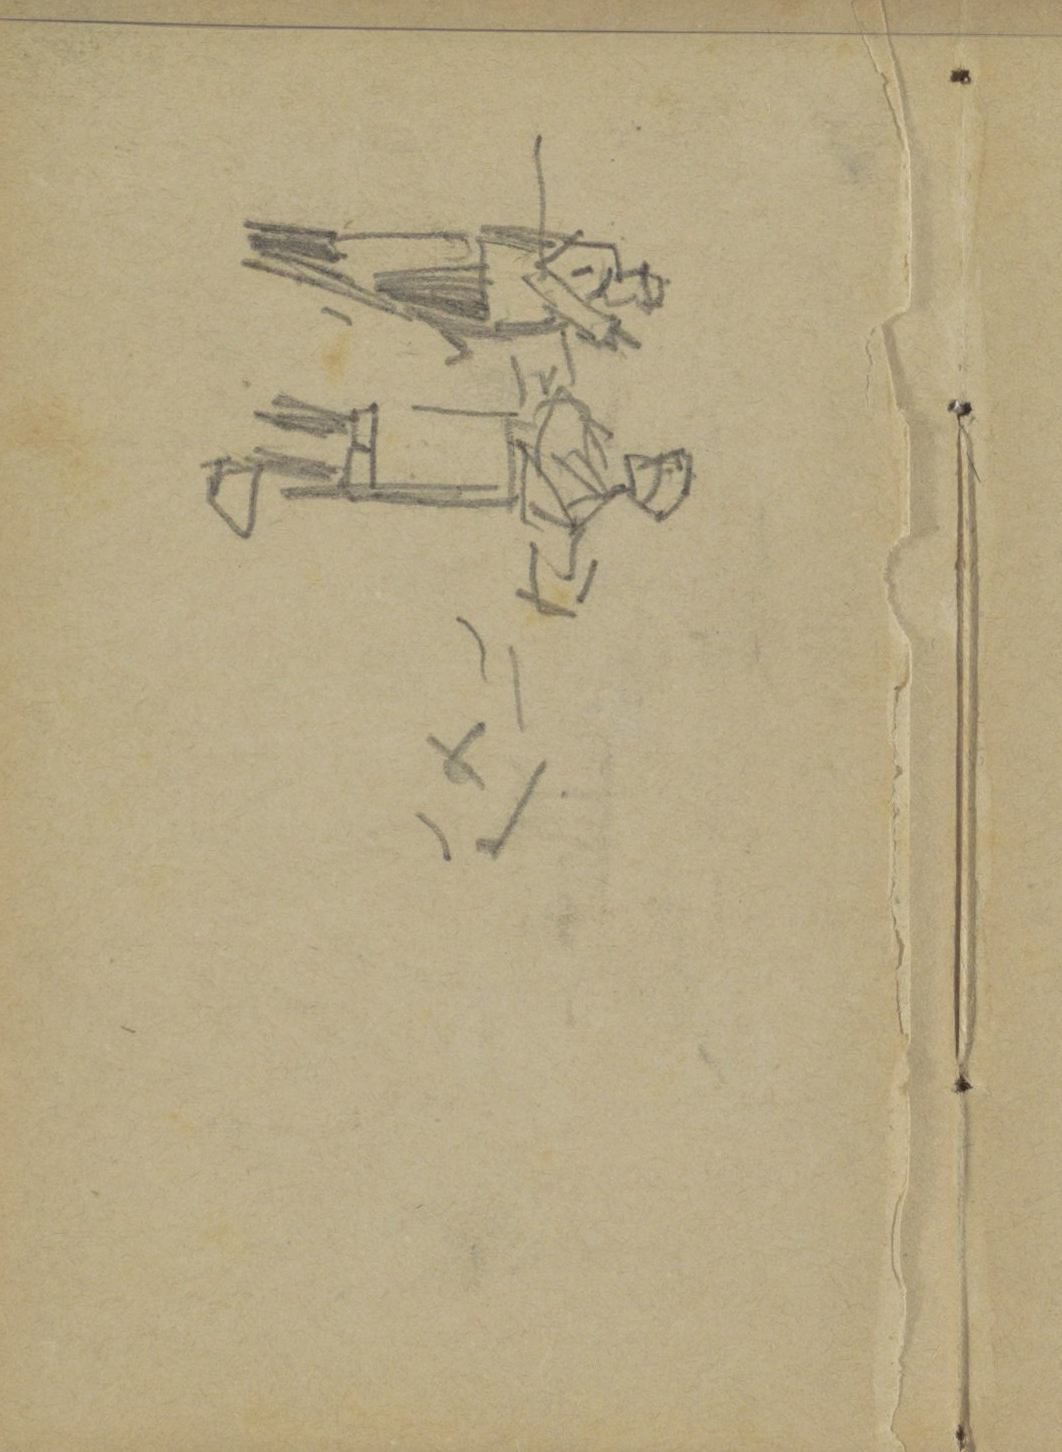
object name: sketchbook leaf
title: Twee soldaten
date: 1887-1891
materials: paper, pencil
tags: division of armed forces (+ land forces)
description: Pagina 97 uit een schetsboek met 83 bladen.